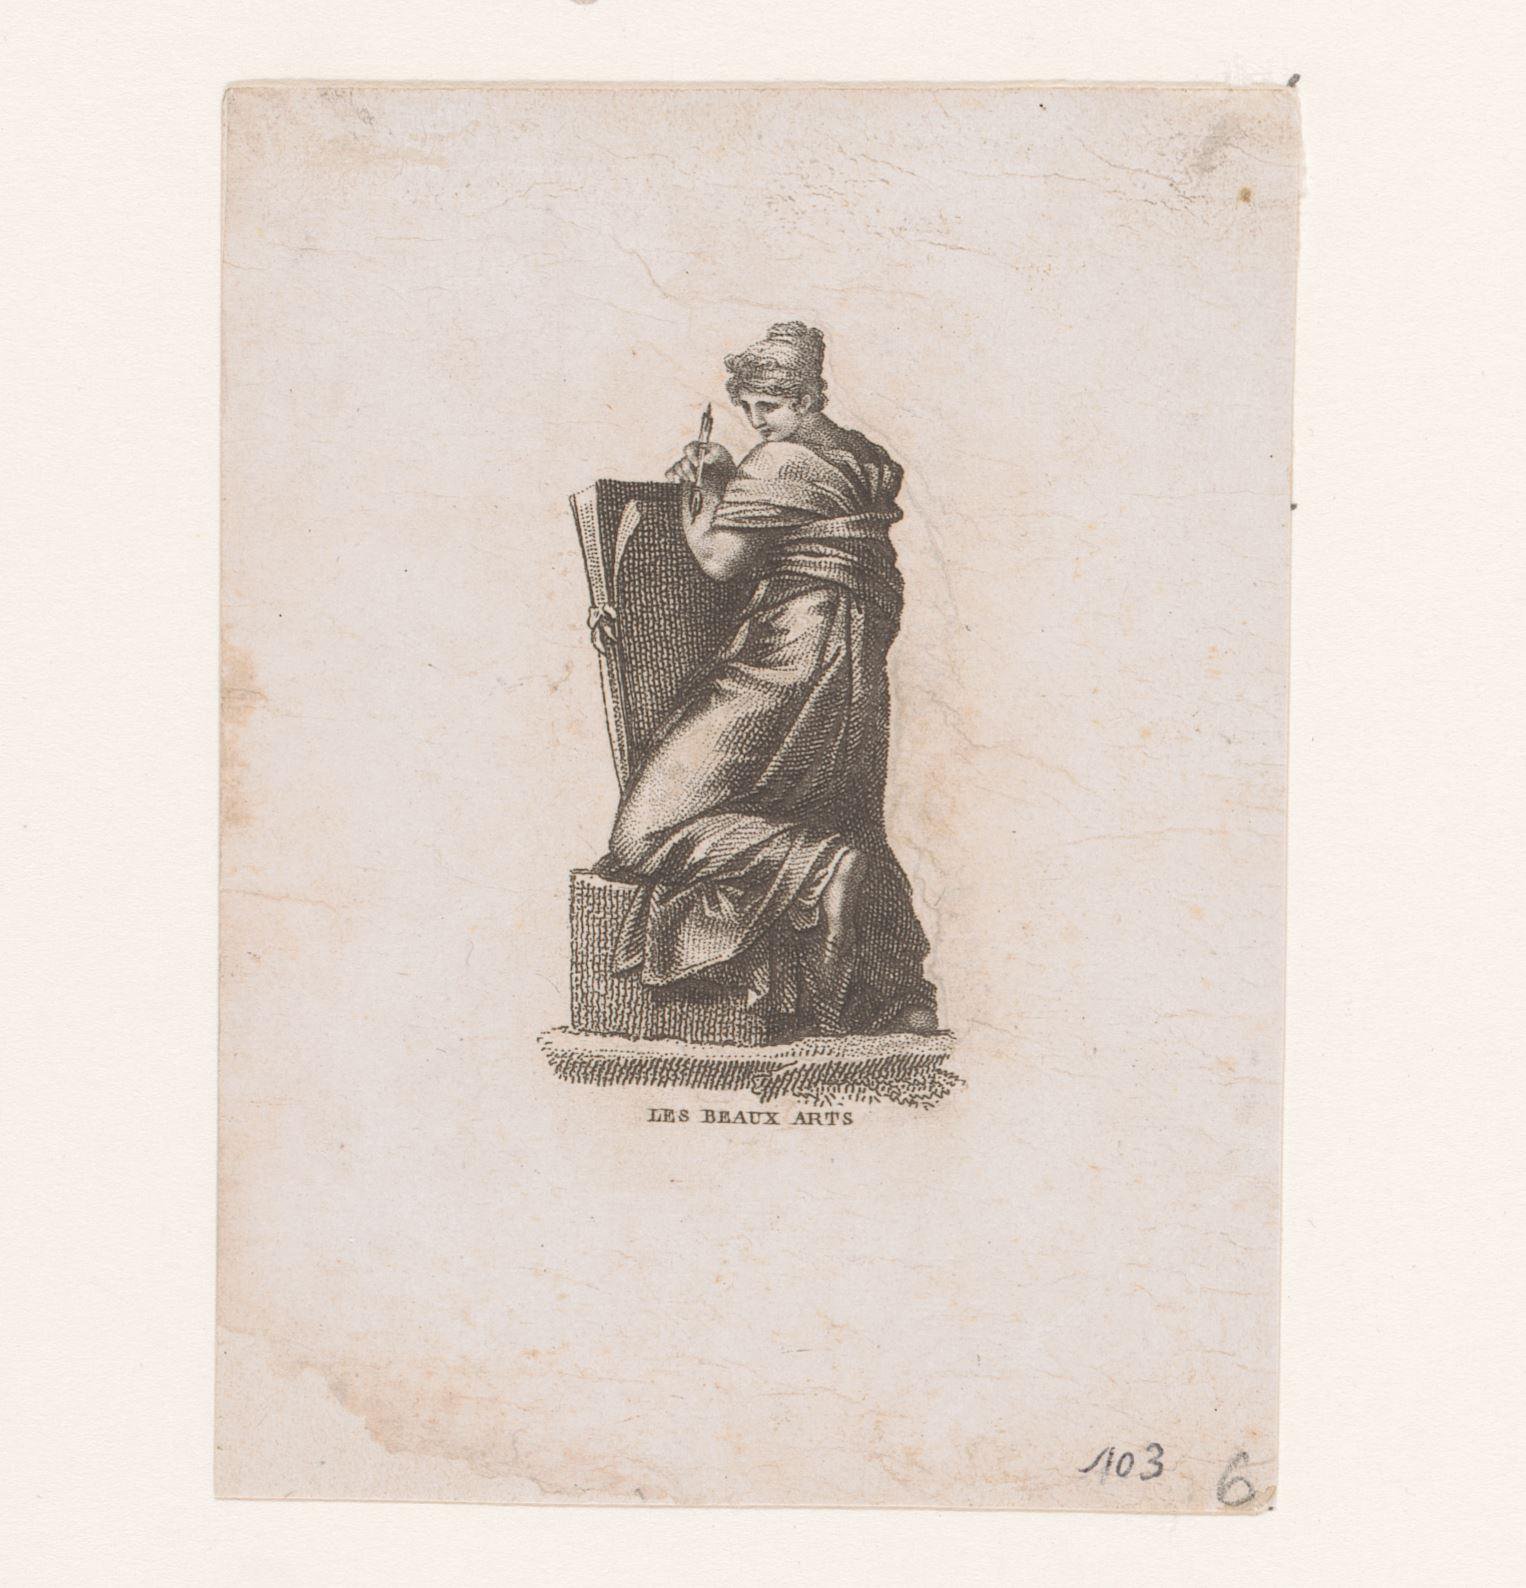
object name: print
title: Les Beaux Arts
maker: Anonymous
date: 1813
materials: paper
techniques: etching, roulette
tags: symbolic representations, allegories and emblems ~ art; 'arte' (ripa)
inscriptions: collector's mark: Lugt 2228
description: Serie naar de figuren die als decoratie gebruikt zijn in het stadhuis, tijdens het huwelijk van Napoleon I Bonaparte en Marie Louise van Oostenrijk in 1810.